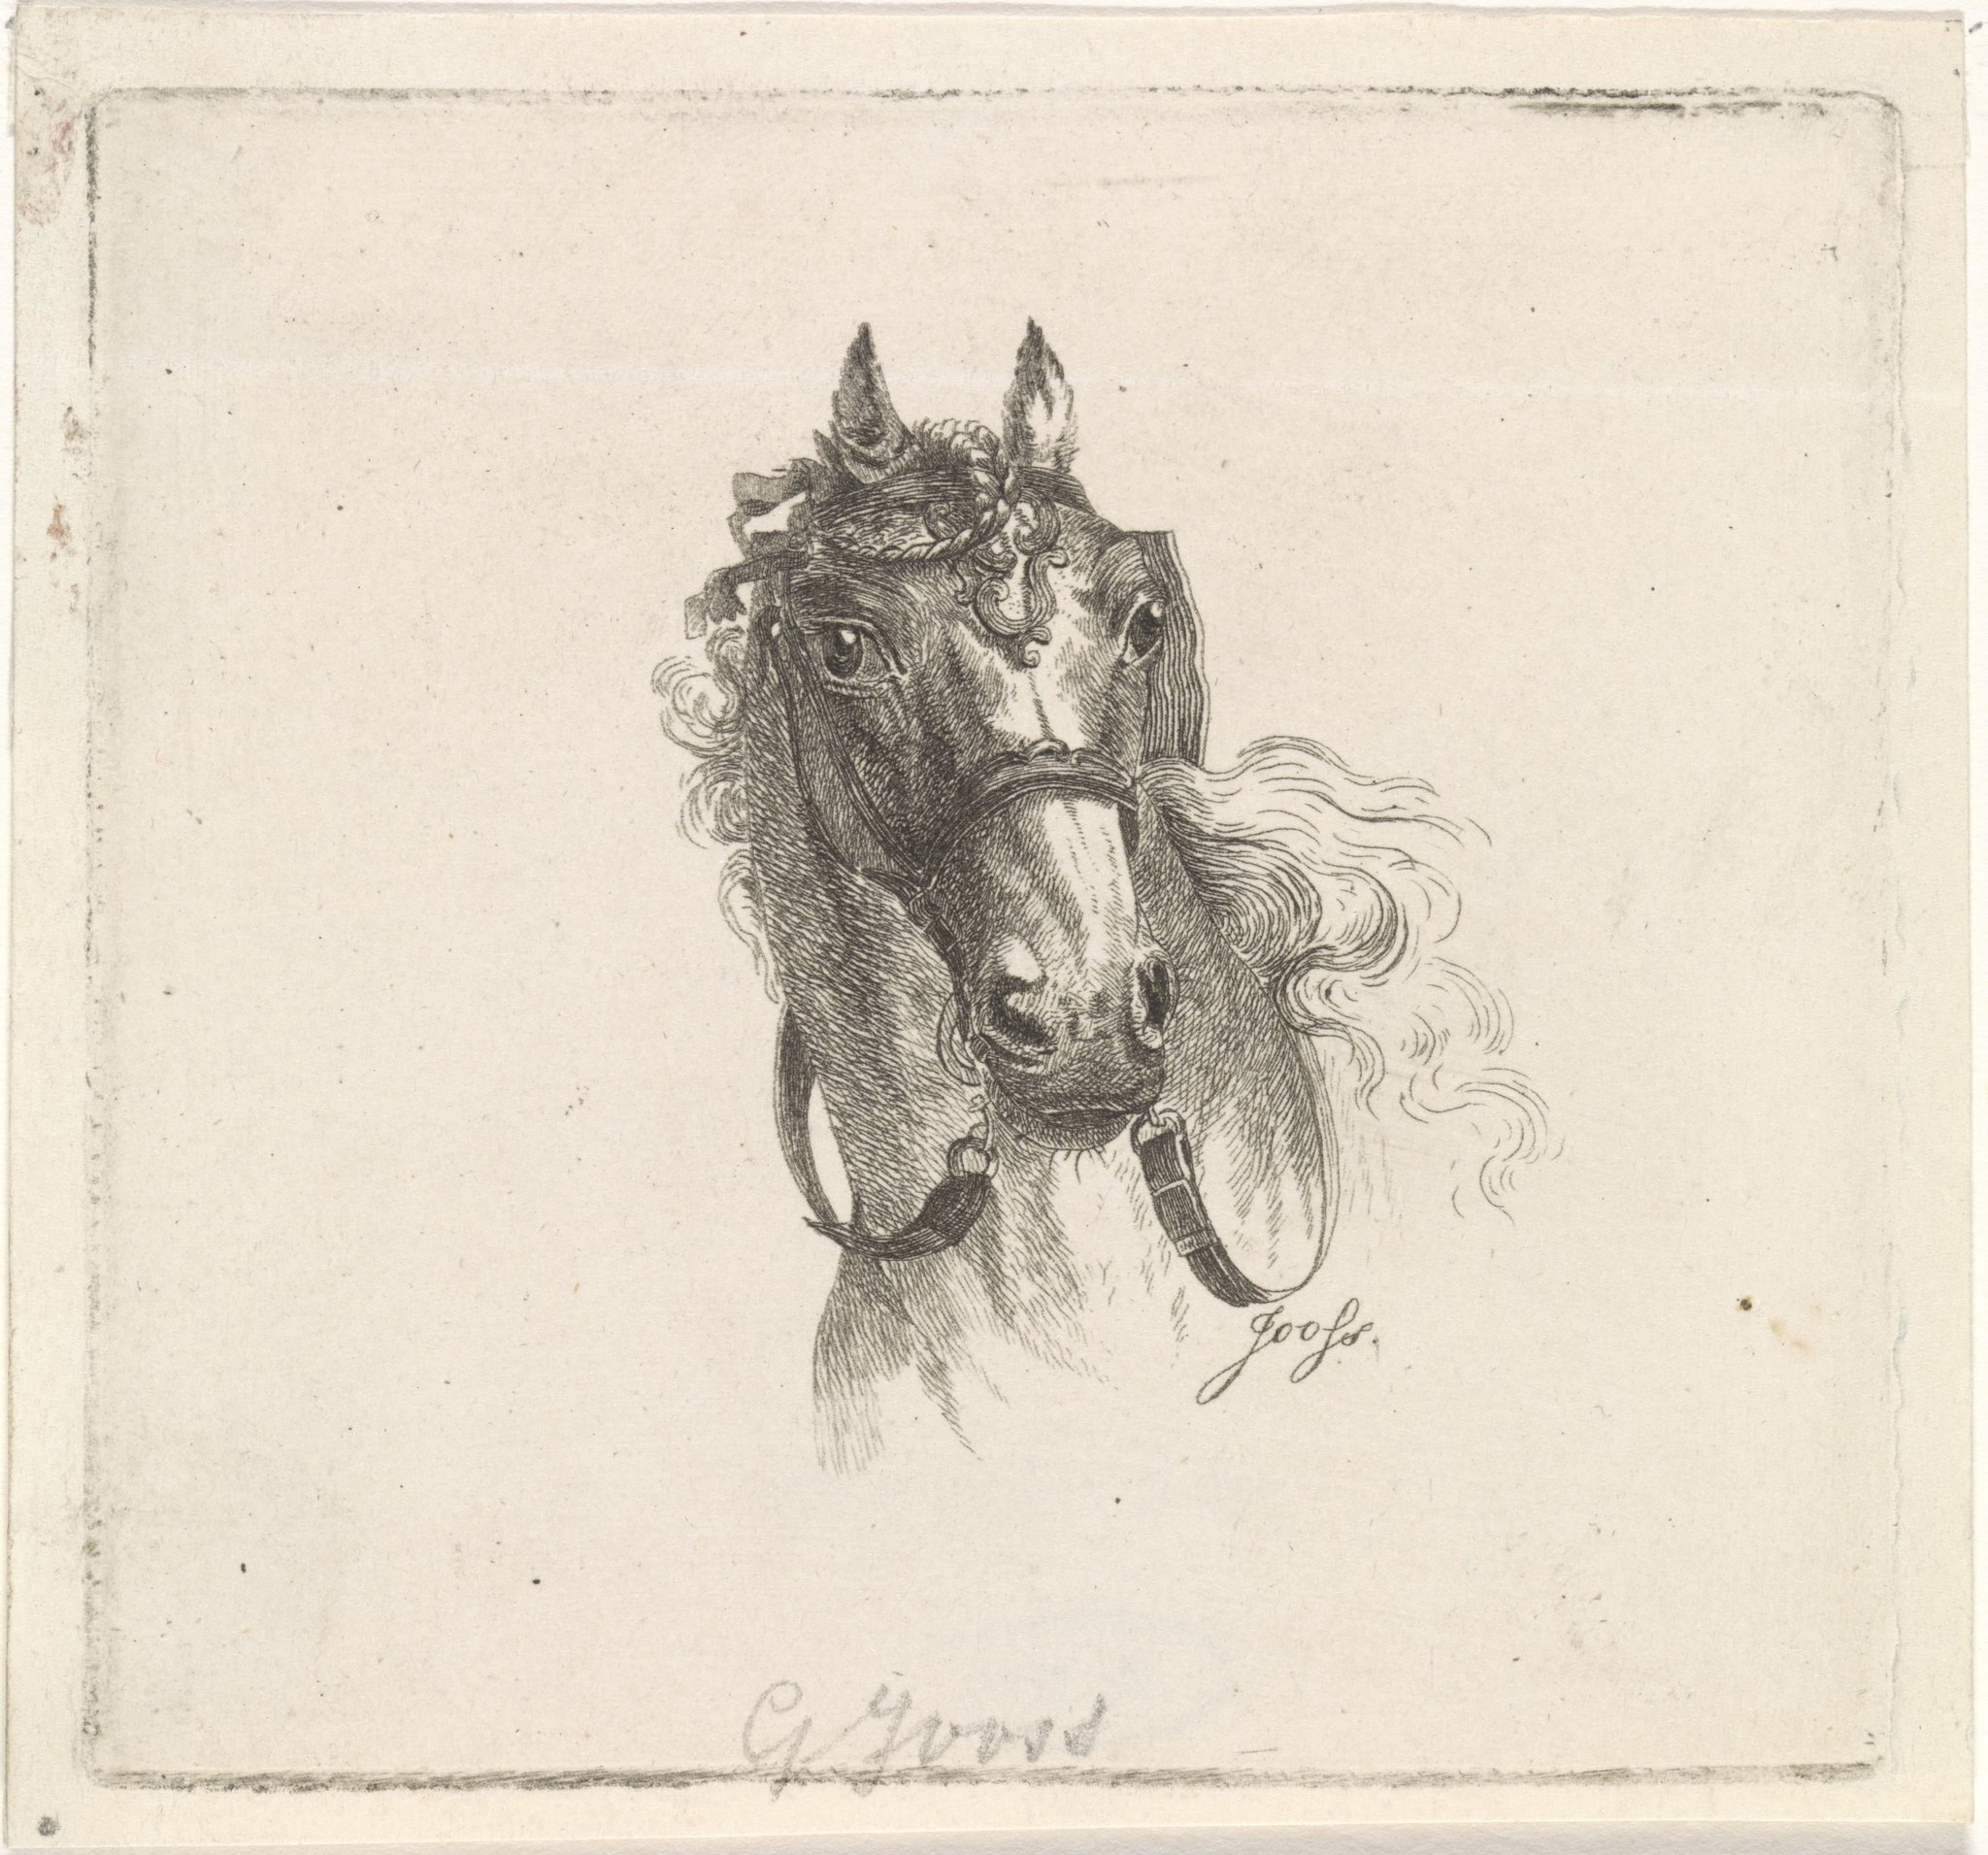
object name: print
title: Hoofd van een paard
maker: george jooss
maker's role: print maker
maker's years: 1799-1845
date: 1814-1845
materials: paper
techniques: etching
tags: horses and kindred animals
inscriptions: collector's mark: Lugt 2228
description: Hoofd van een paard met een hoofdstel om.